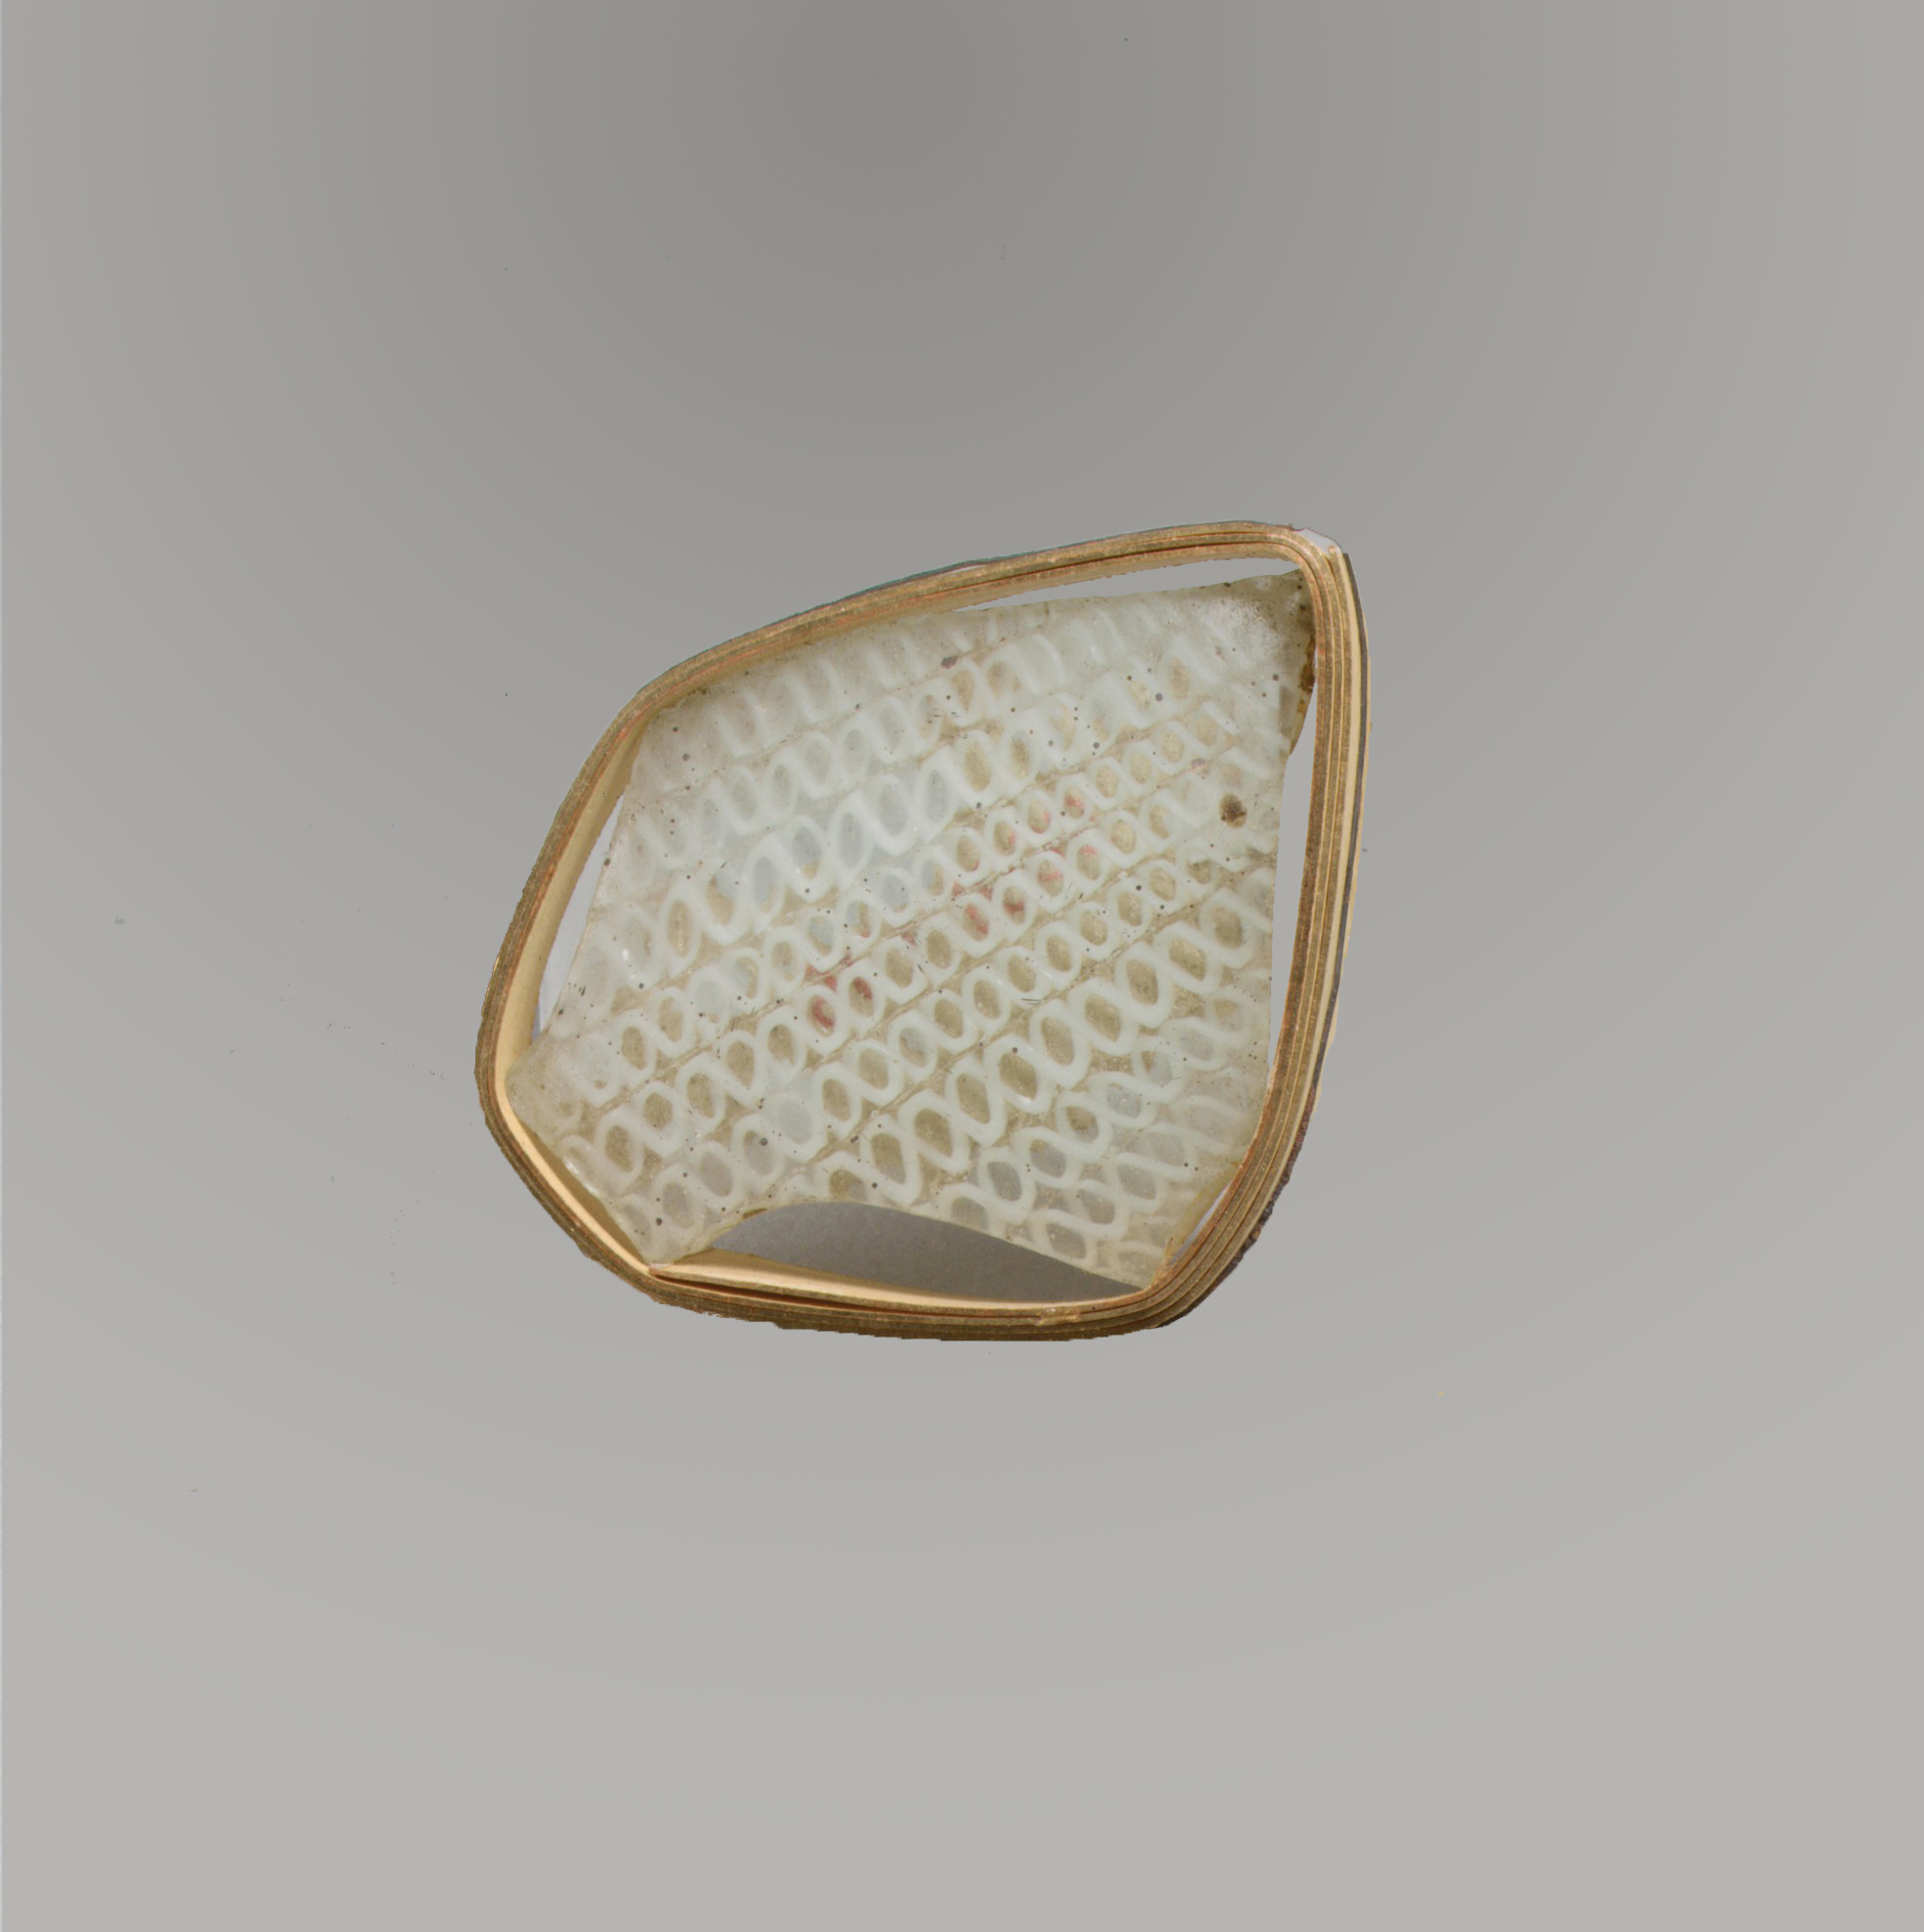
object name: fragment, network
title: Glass network mosaic fragment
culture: roman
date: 34 BCE-33 CE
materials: glass